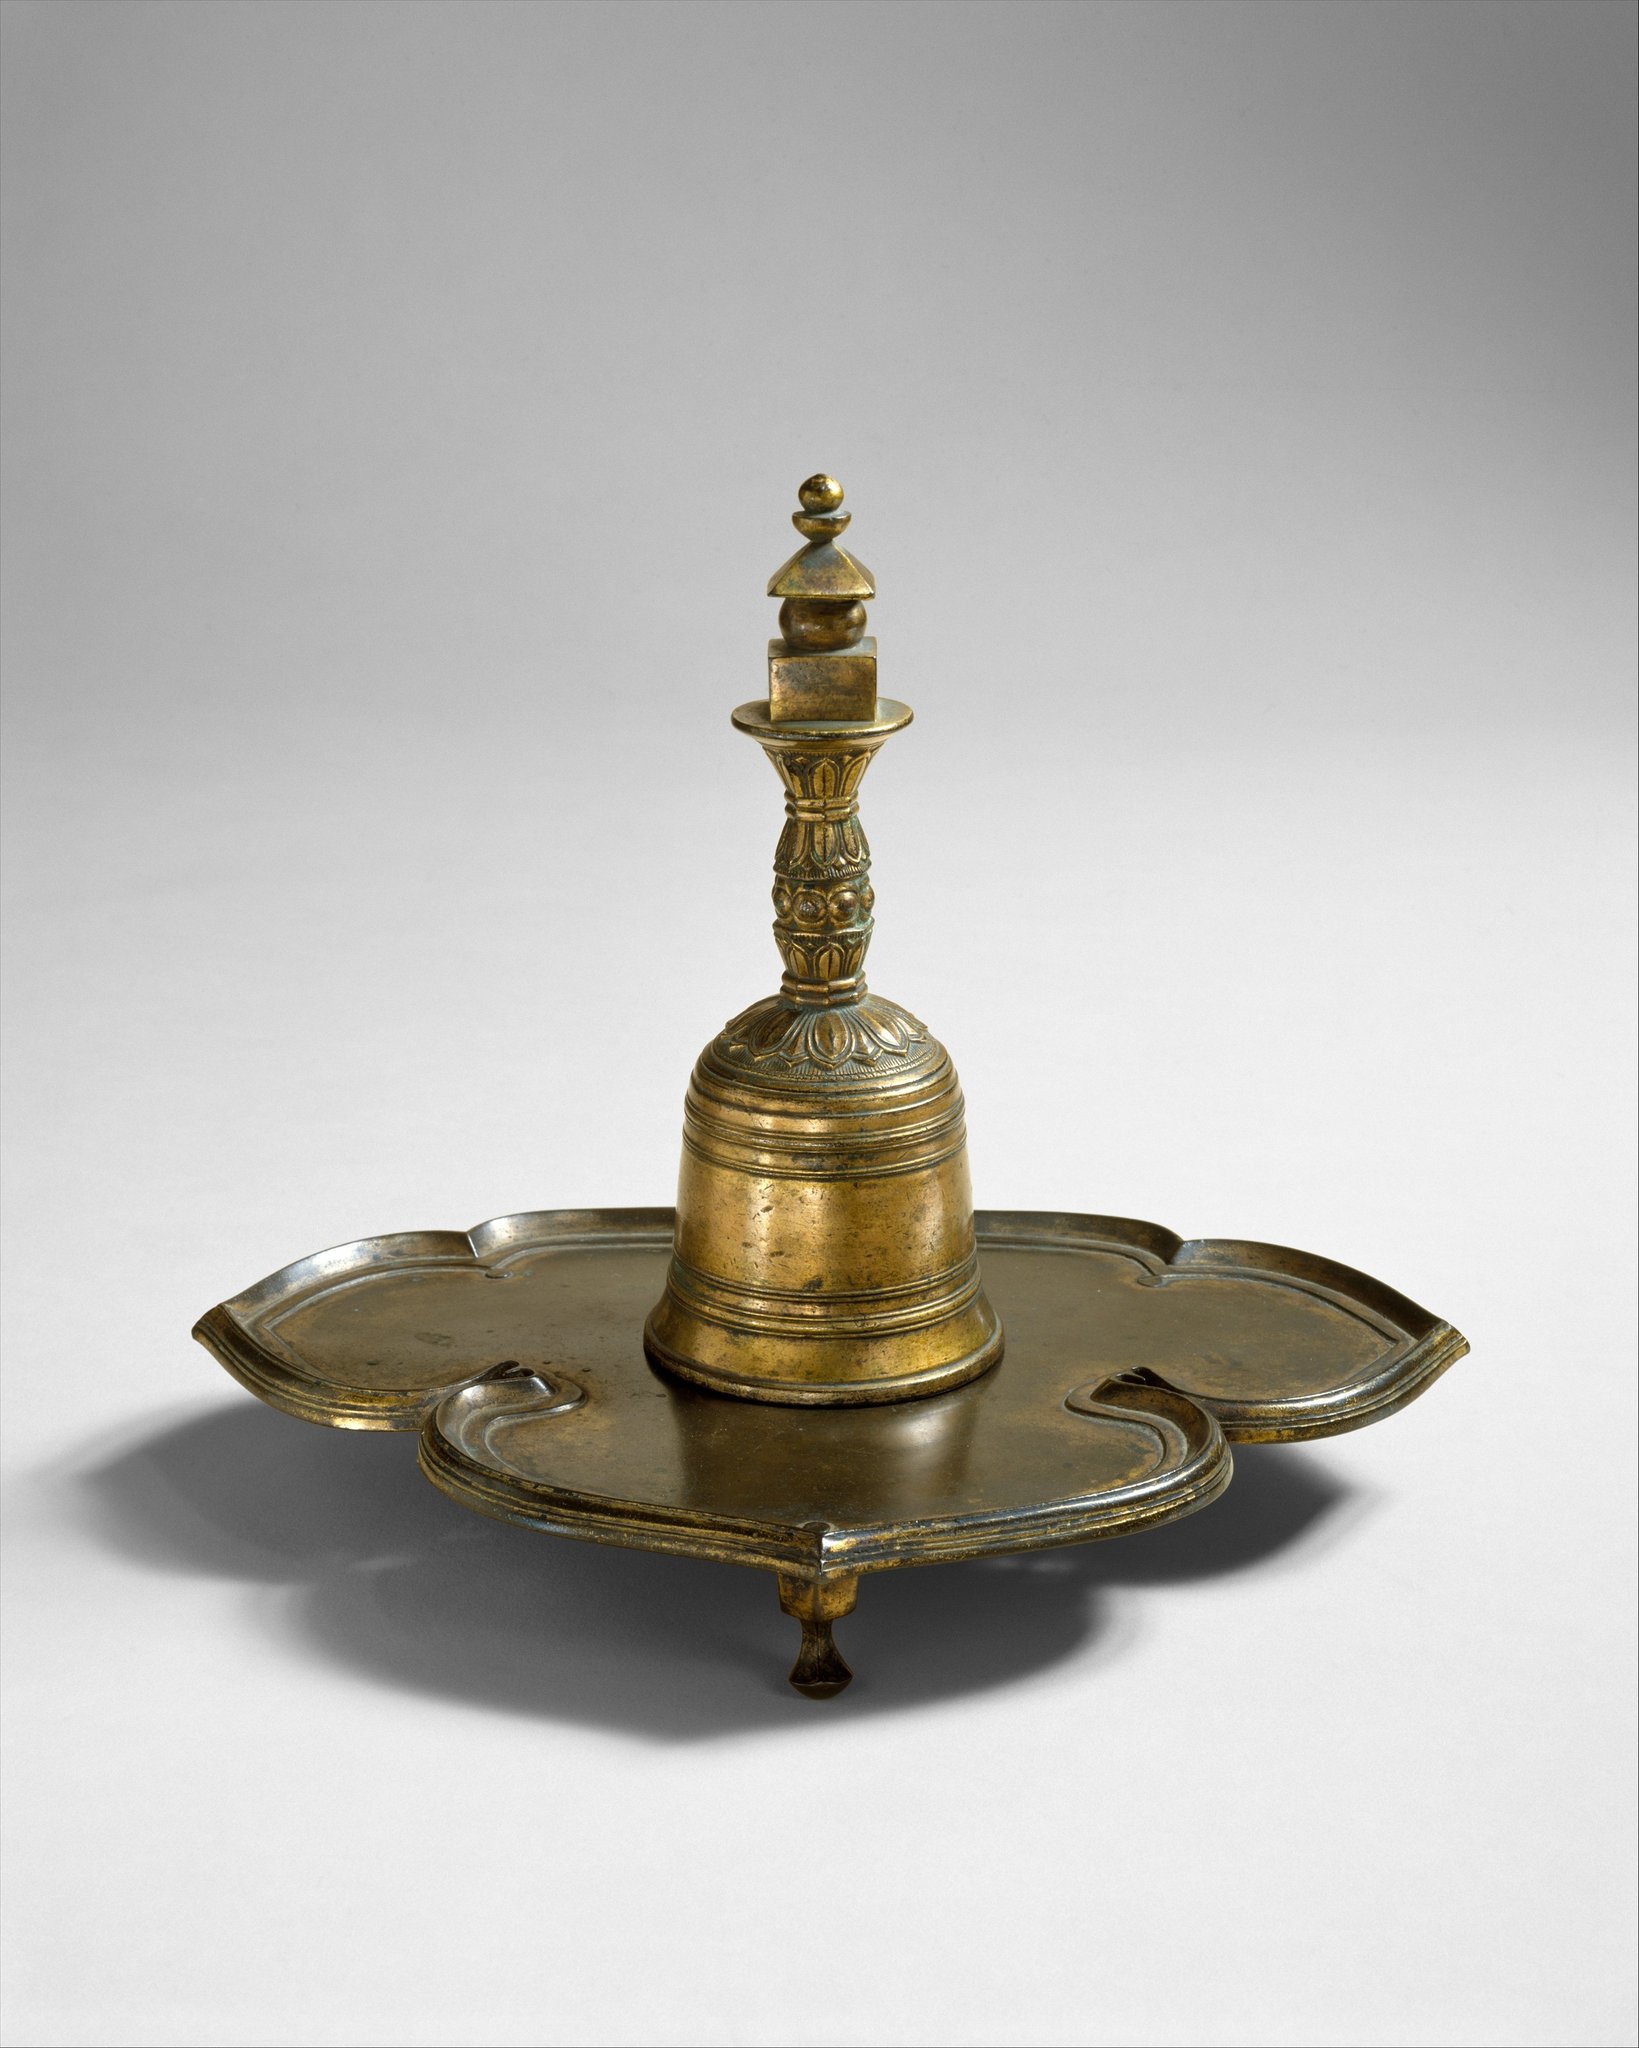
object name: bell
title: Bell with Pagoda-Shaped Handle (Tōrei) and Three-Footed Stand (Kongōban)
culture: japanese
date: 1201-1300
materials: gilt bronze